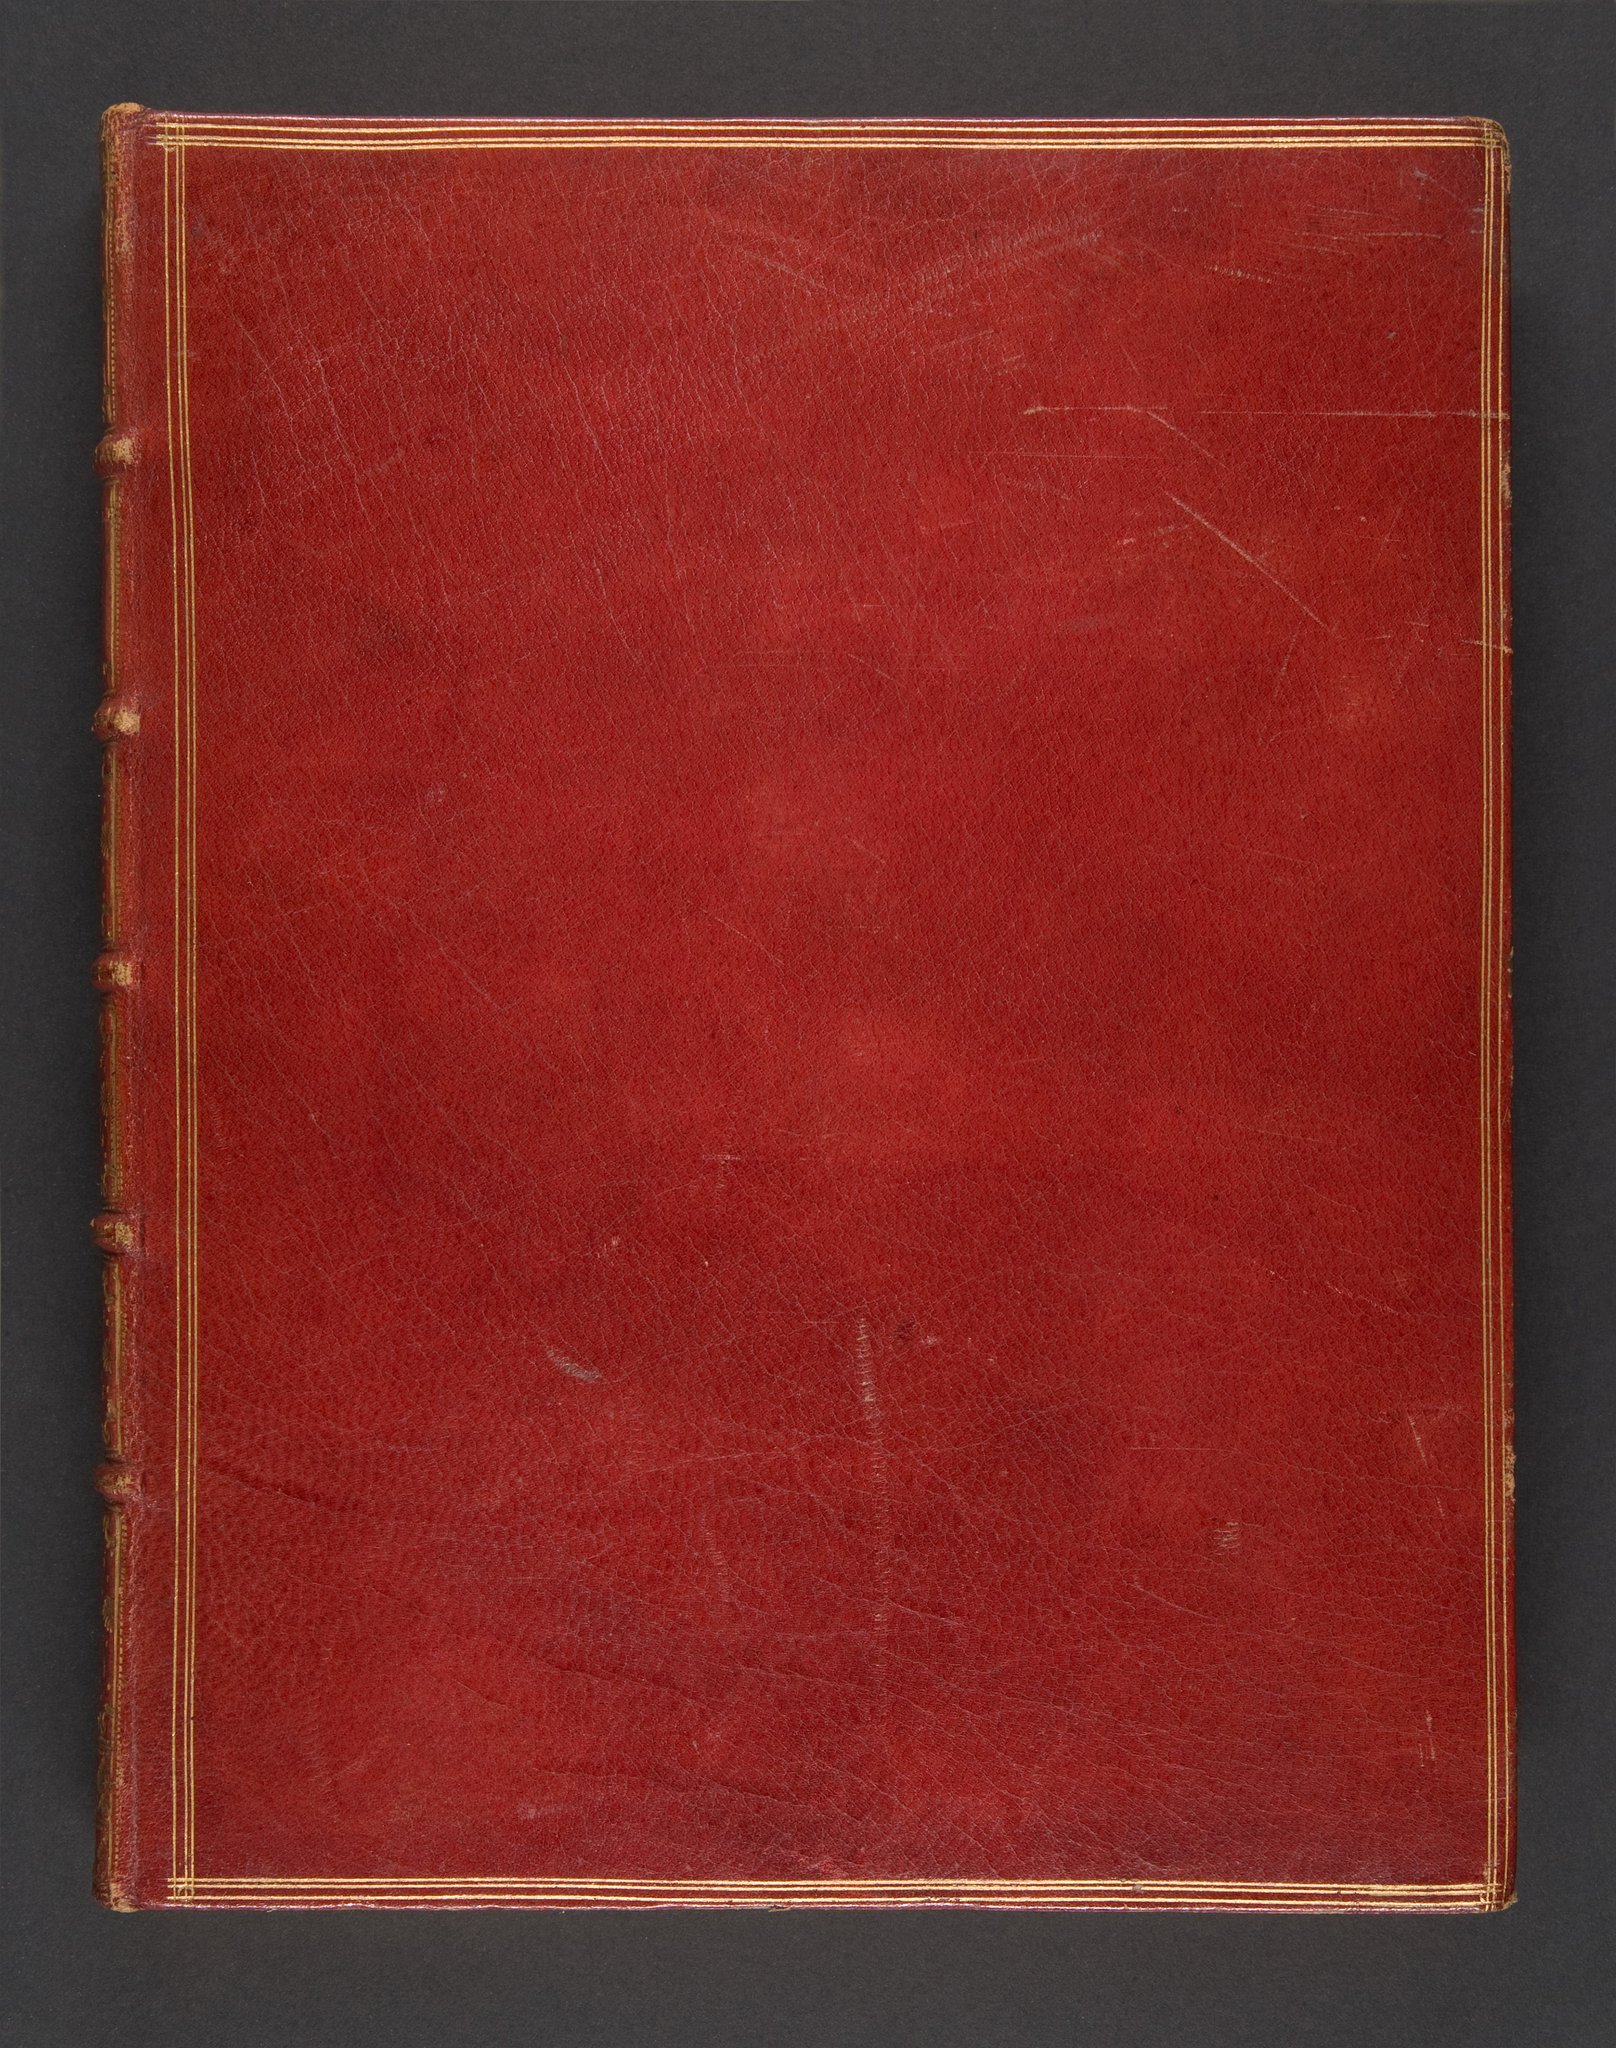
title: Epistole eroiche di P. Ovidio Nasone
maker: ovid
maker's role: author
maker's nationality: roman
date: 1762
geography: france